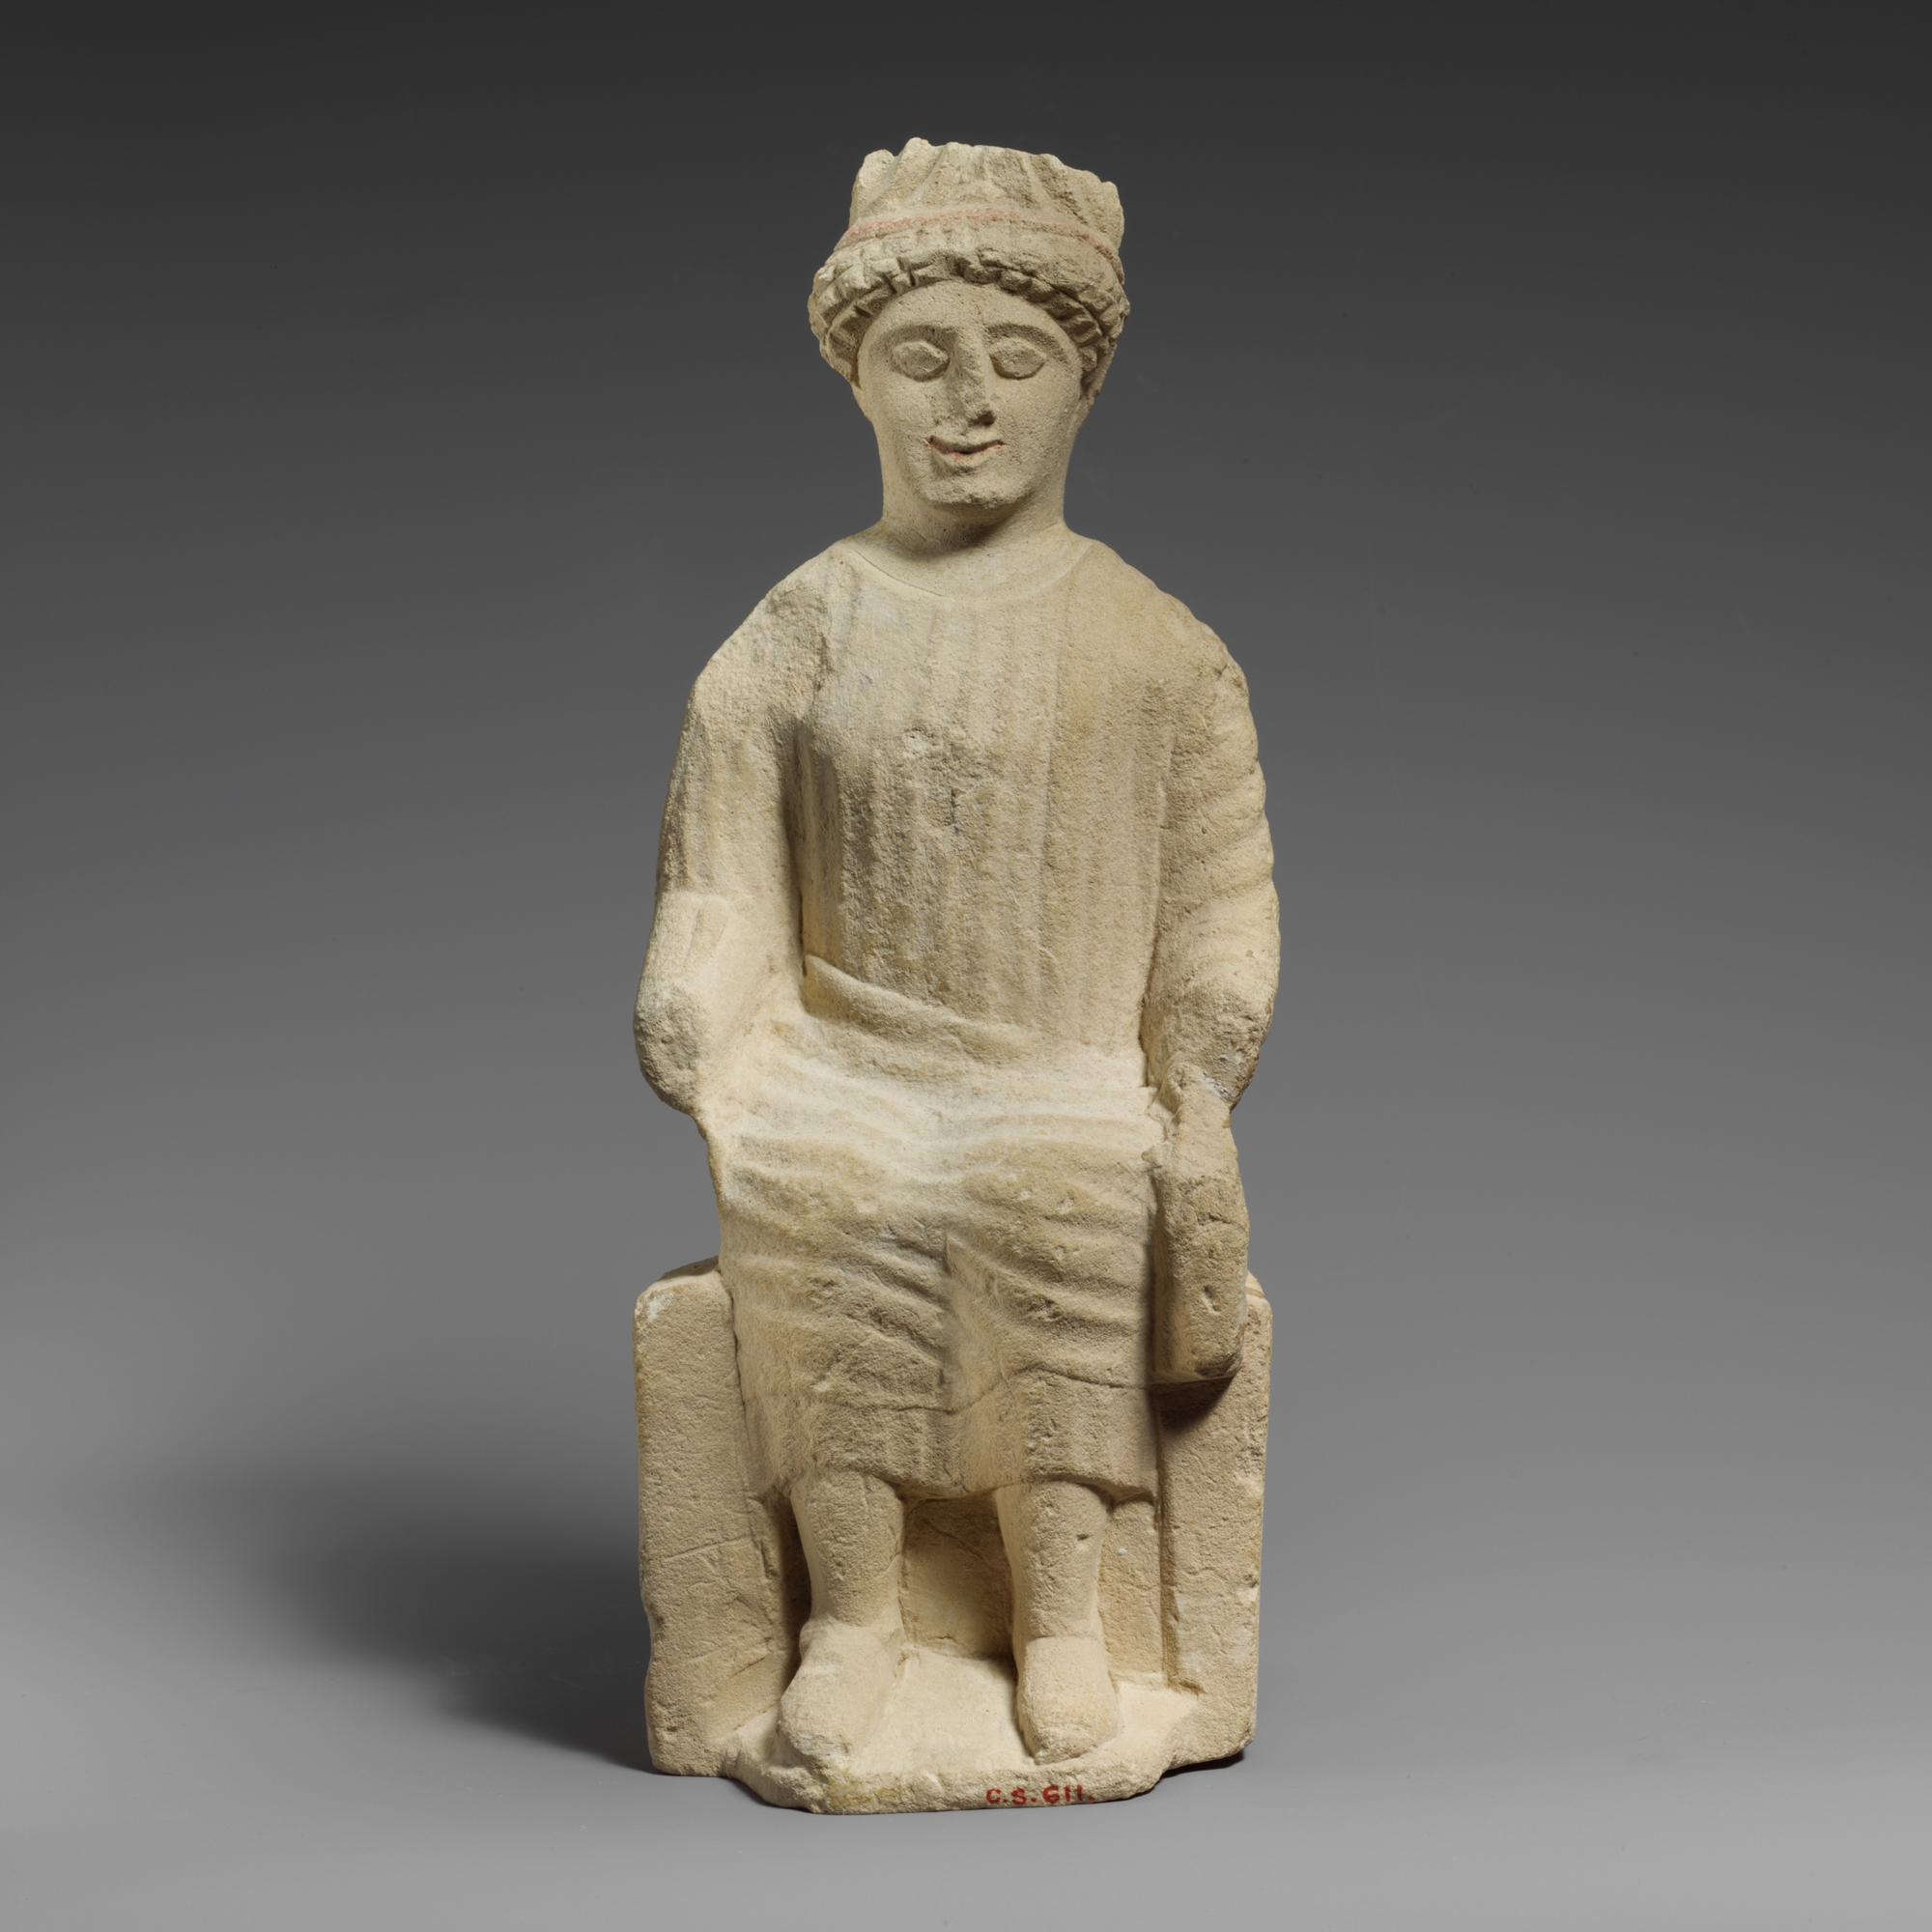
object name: statuette of a poet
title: Limestone statuette of a seated beardless male votary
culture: cypriot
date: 450-401 BCE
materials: limestone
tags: men